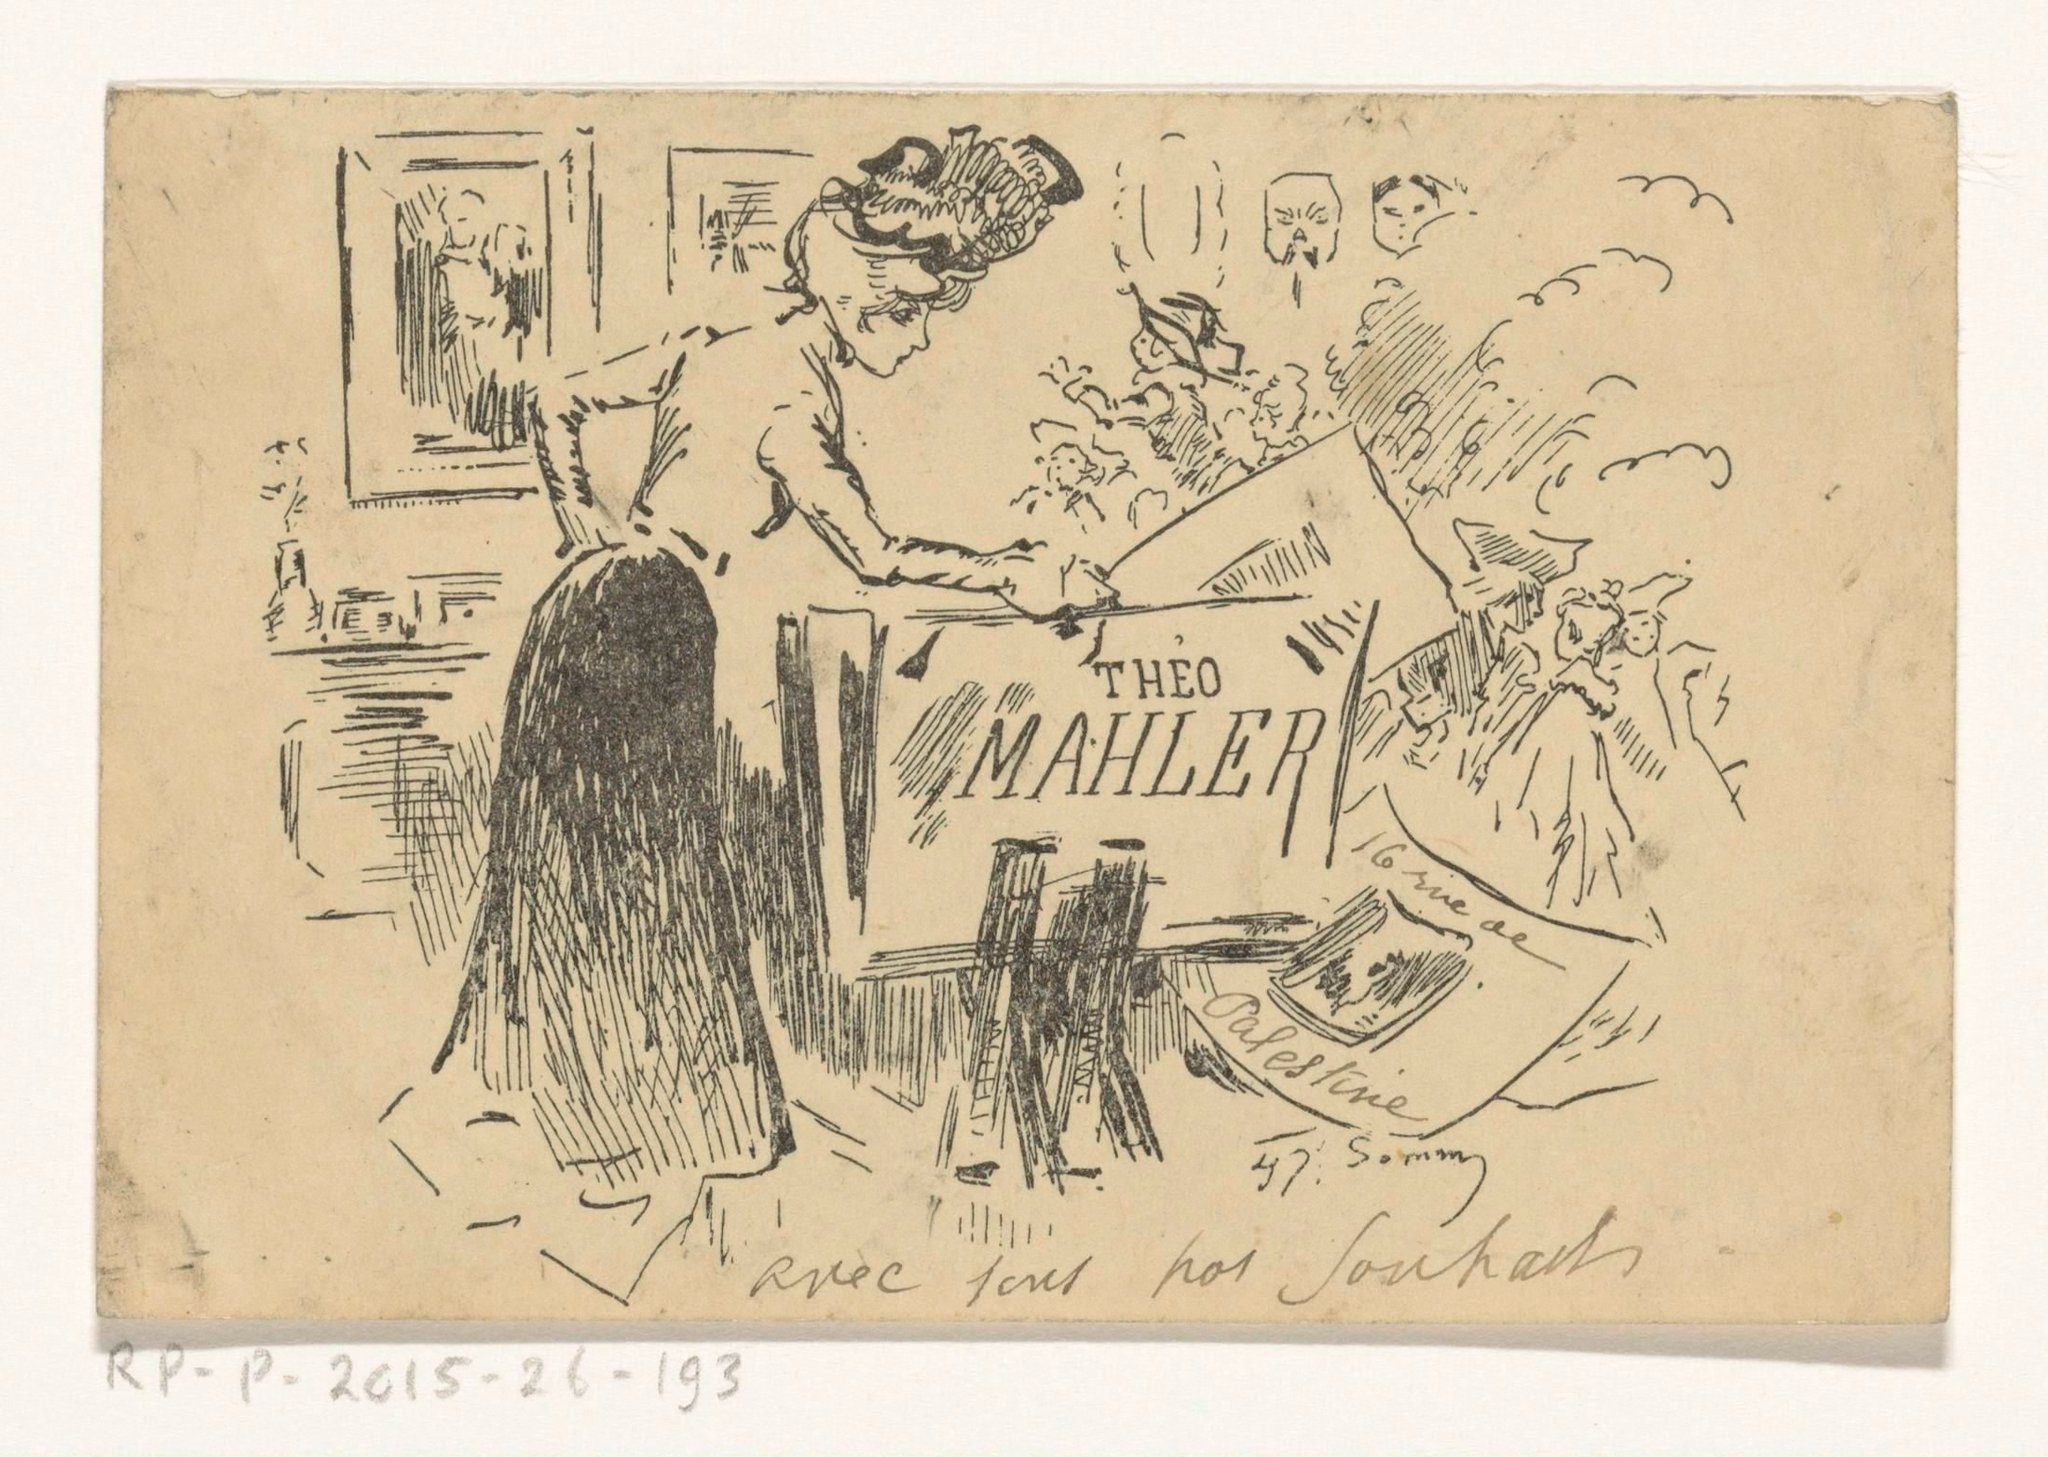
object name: print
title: Visitekaartje van prenthandelaar Theo Mahler te Parijs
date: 1854-1907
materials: paper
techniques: lithograph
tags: print, e.g.: engraving, etching, lithograph, art dealer, art collecting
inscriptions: collector's mark: Lugt 4780, inscription: ‘16 rue de Palestine/ Avec tous nos souhaits’, collector's mark: Lugt 2228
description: Een vrouw bekijkt de inhoud van een prentstandaard.